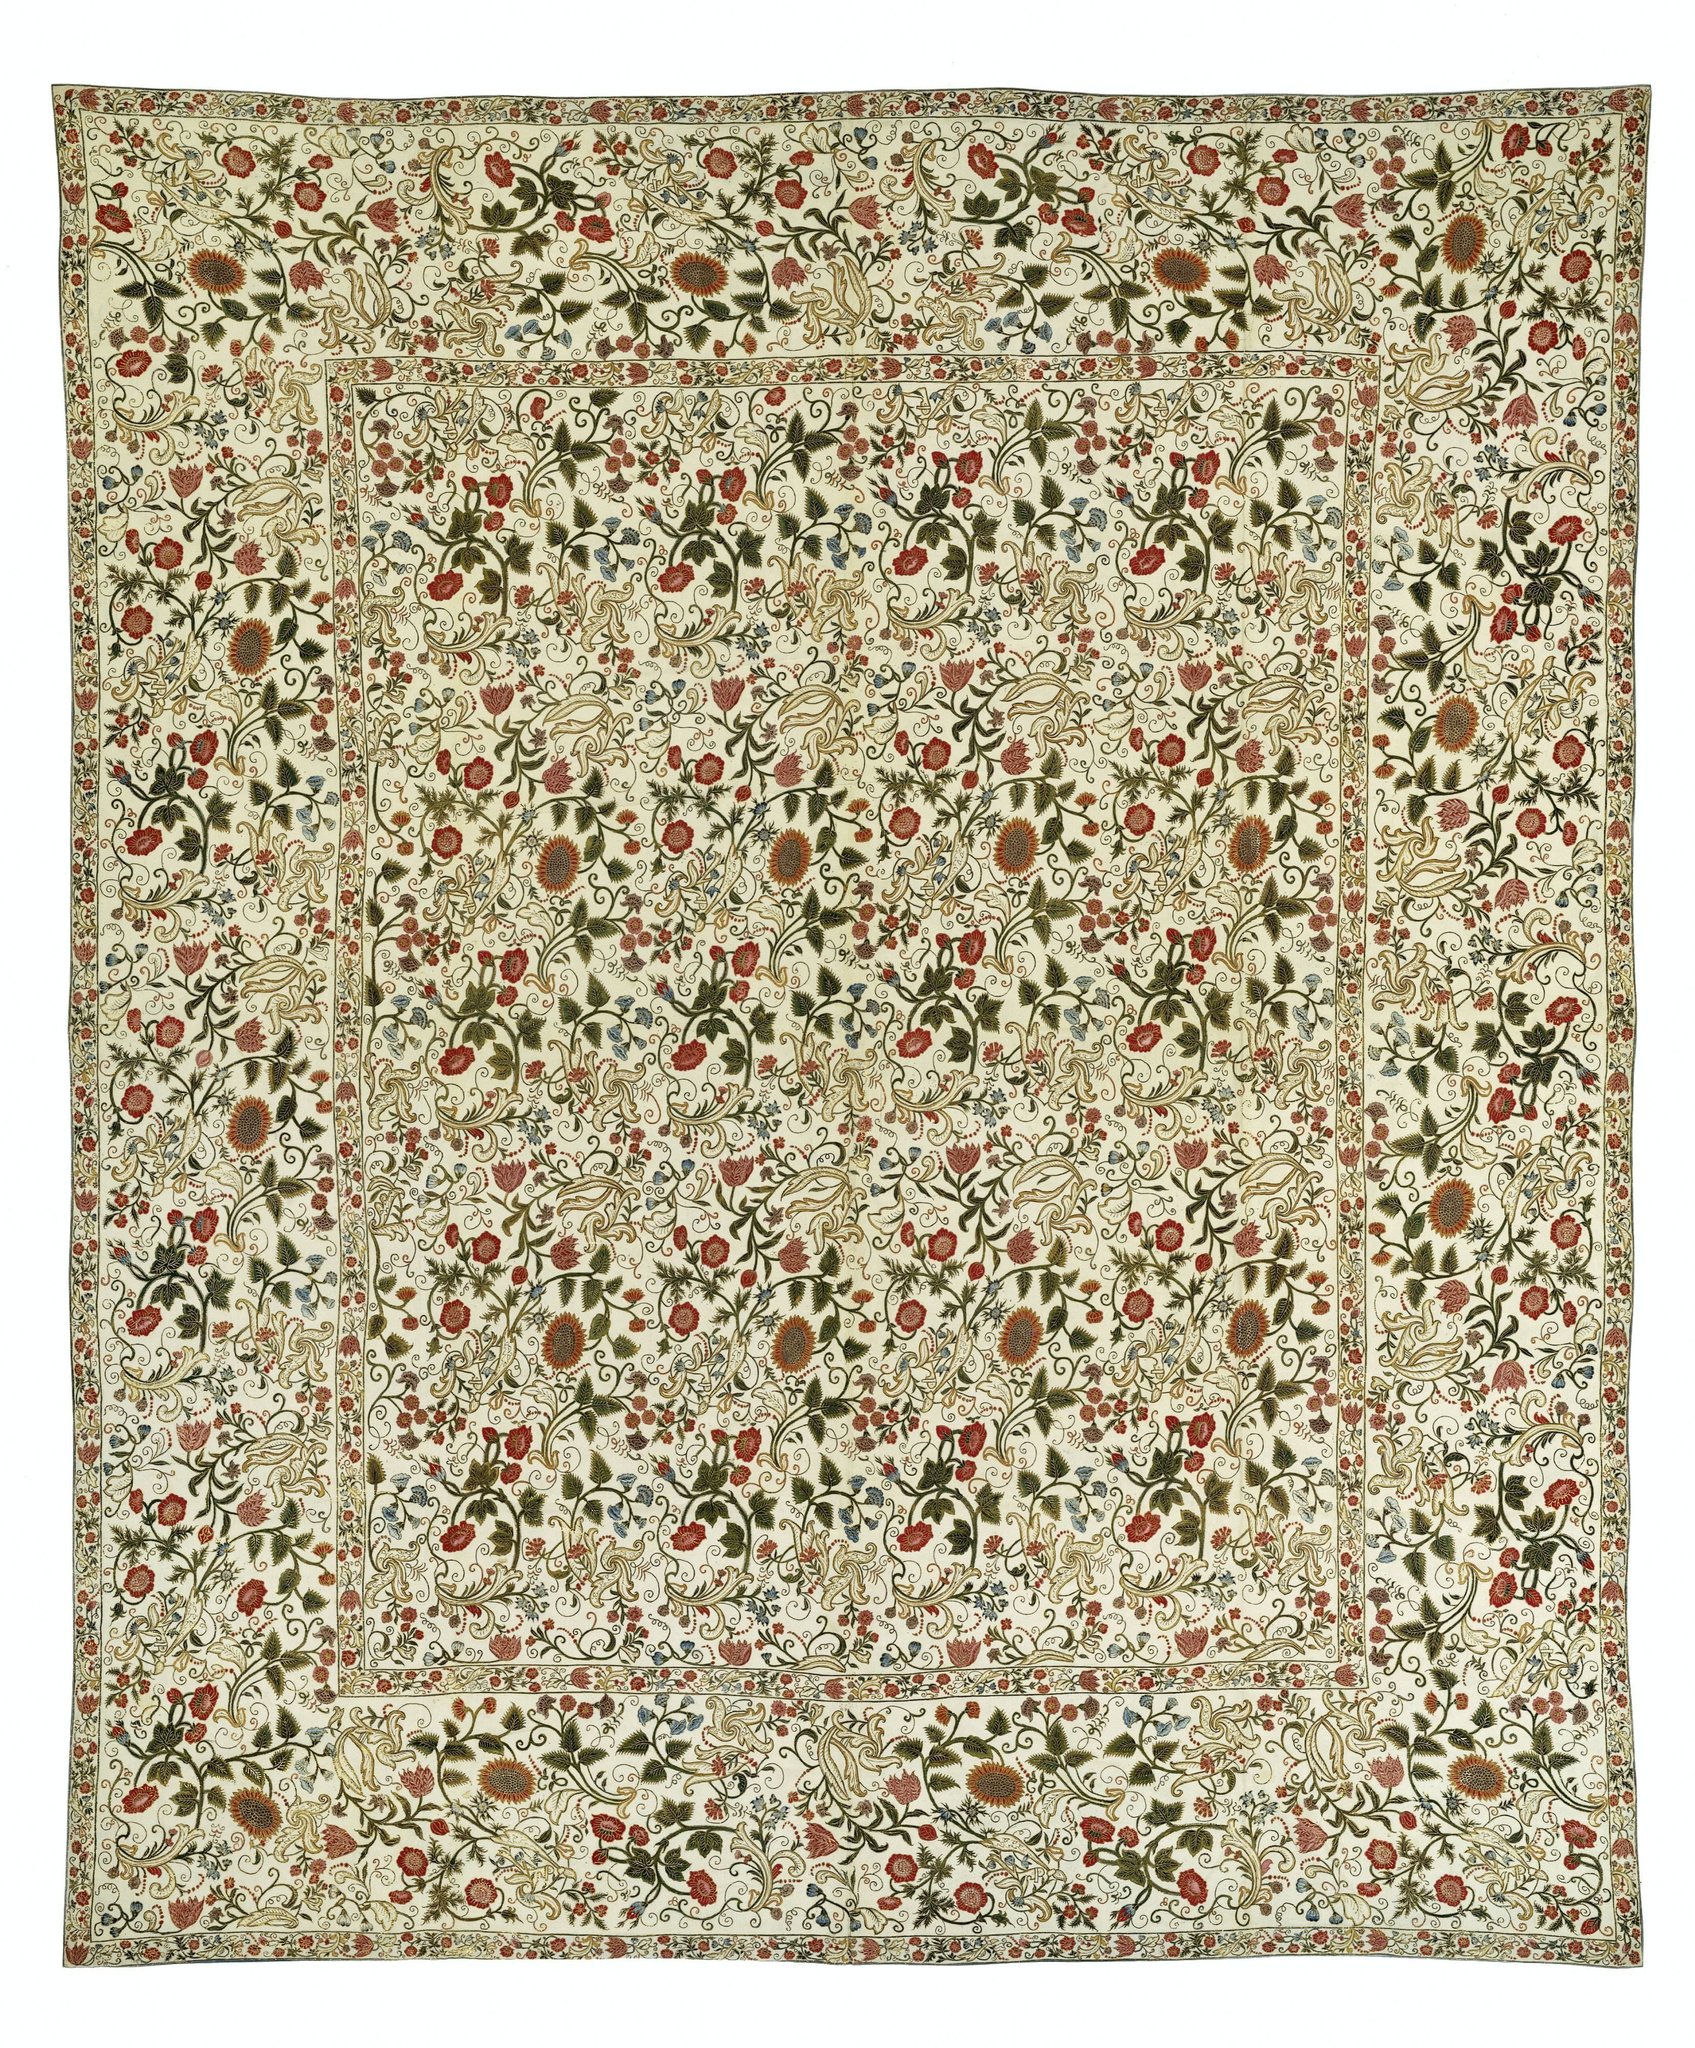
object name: palampore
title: Bedspread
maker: Anonymous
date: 1720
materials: textile, cotton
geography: india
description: The Dutch East India Company exported these beautiful, woodblock-printed cotton fabrics (chintz) in large quantities from India to Japan, where they became extremely popular.